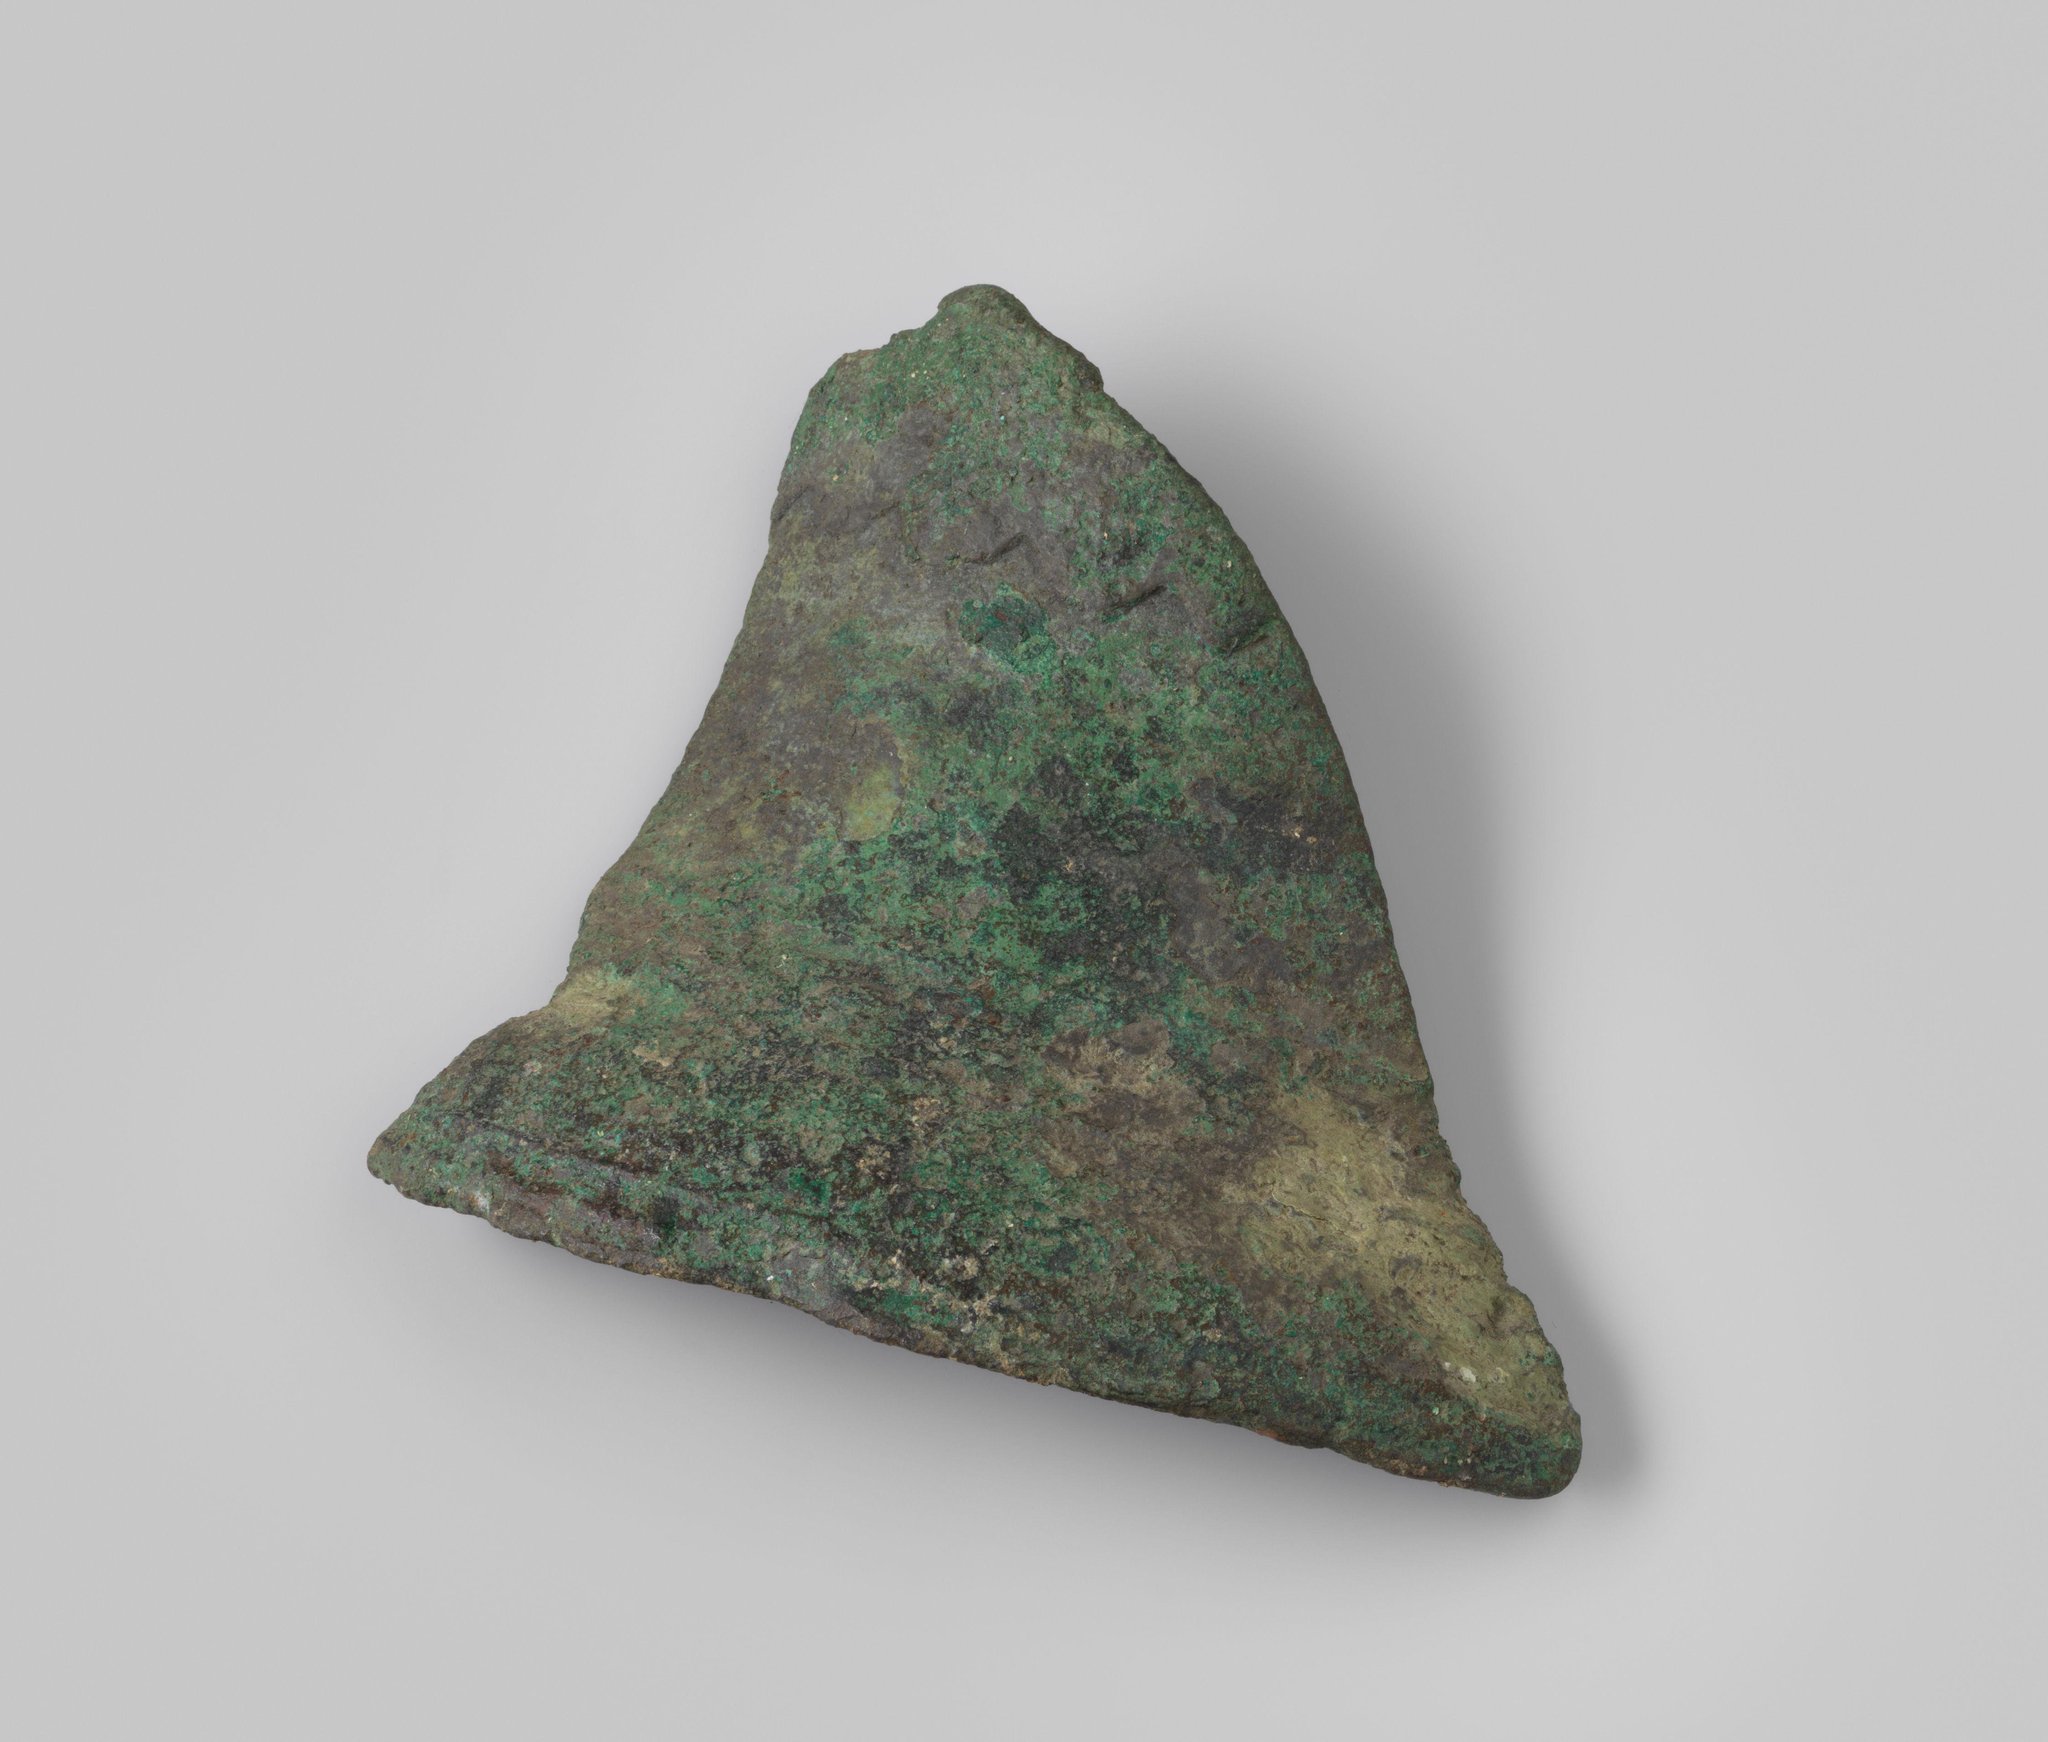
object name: ship bell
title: Fragment of a ship's bell from the wreck of the Dutch East Indiaman Hollandia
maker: Anonymous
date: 1700-1743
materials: copper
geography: netherlands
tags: verenigde oostindische compagnie, hollandia (schip), annet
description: Acoustic, bell (ship's); fragment of rim and body, eroded, concentric band moulding, fits to NG 1980-27H1937/2665.